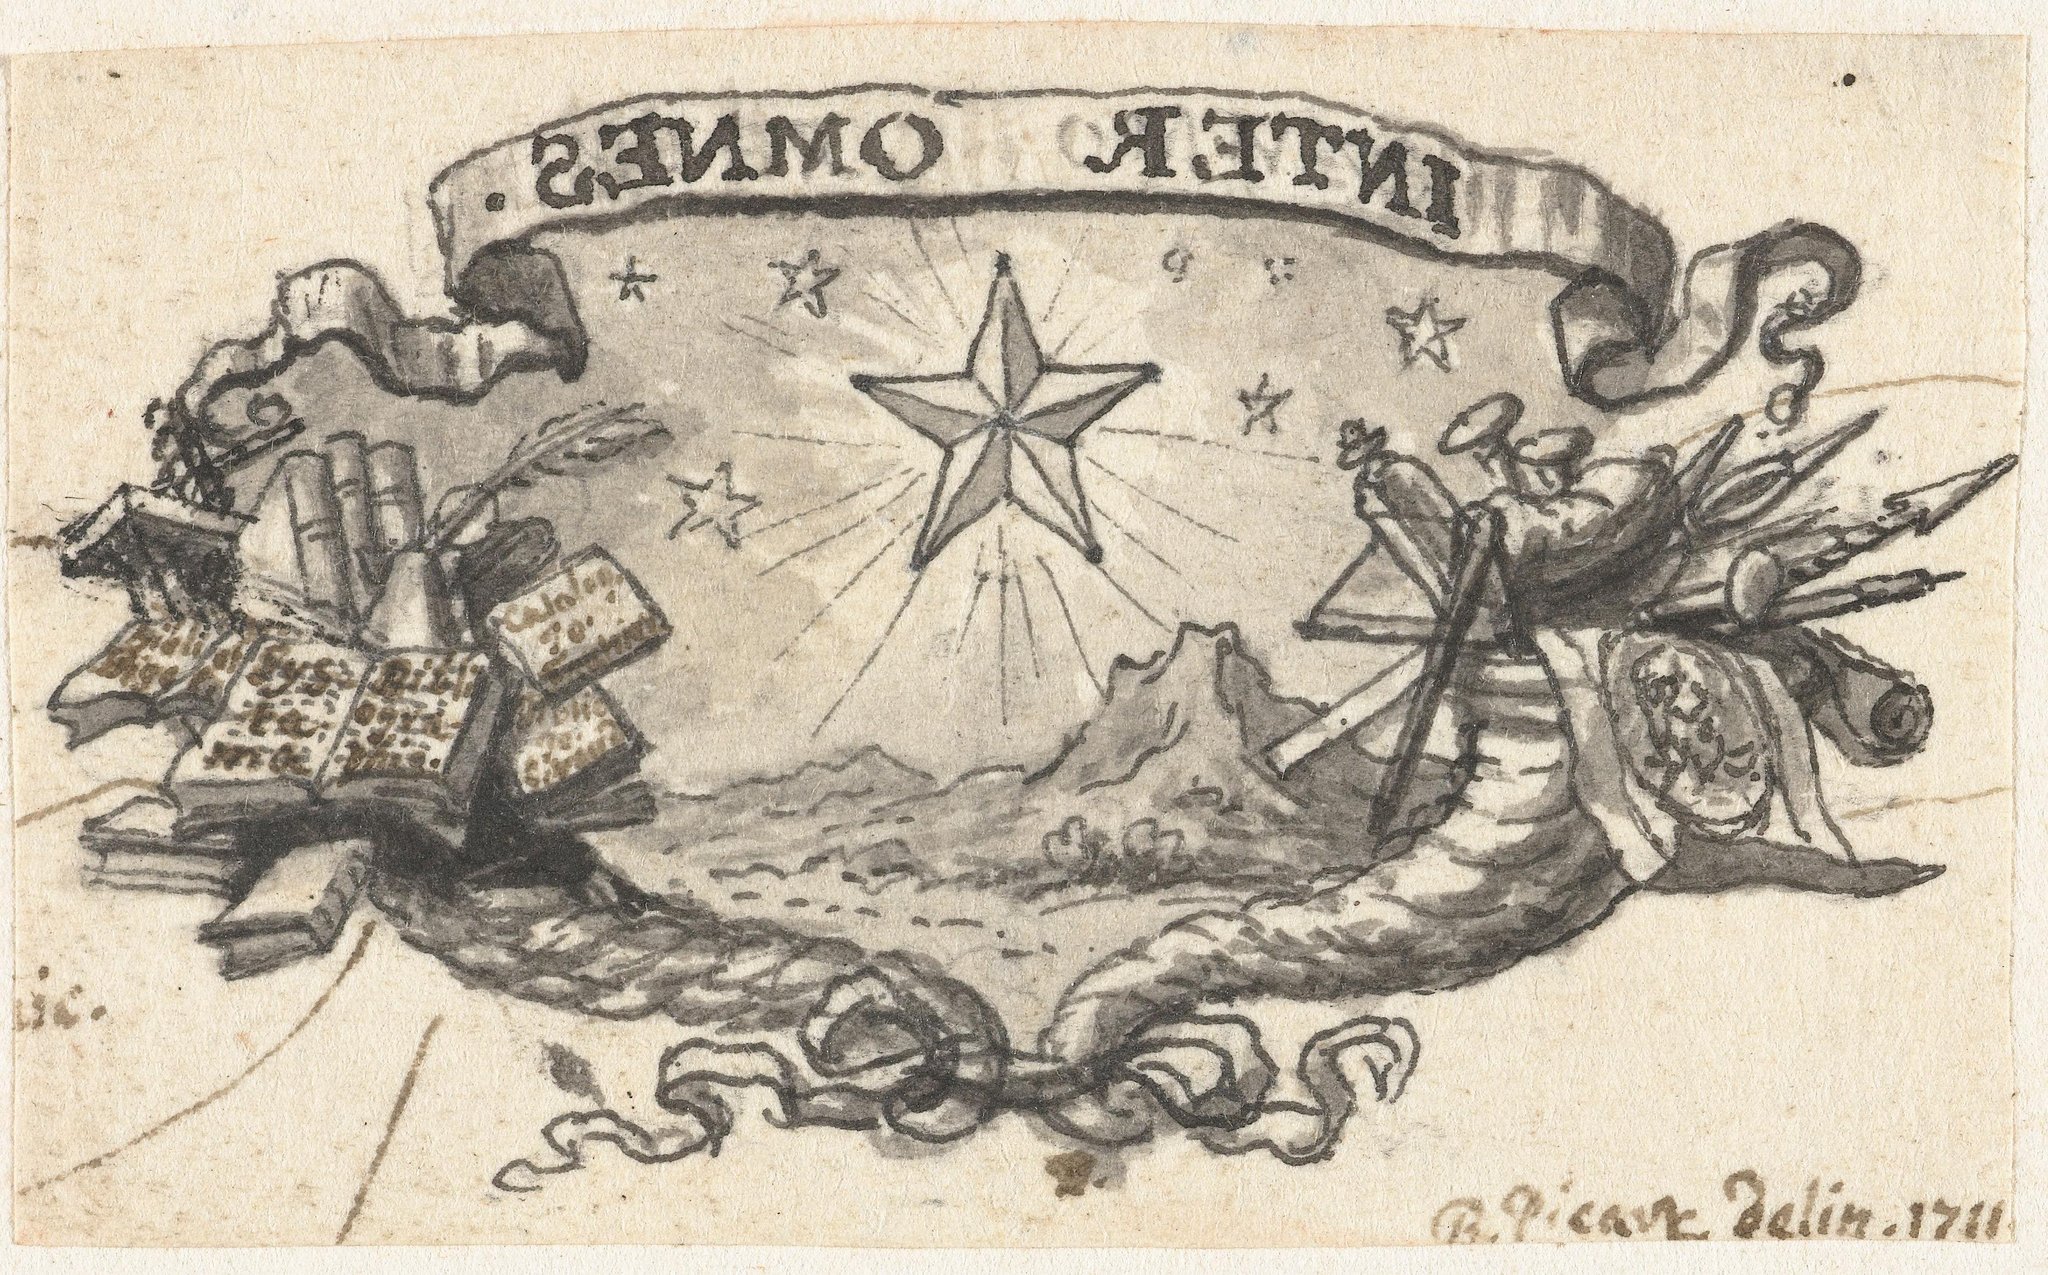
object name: drawing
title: Vignet met ster boven landschap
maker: bernard picart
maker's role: draughtsman, print maker, publisher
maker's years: 1673-1733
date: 1711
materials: ink, paper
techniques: brush, pen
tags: stars